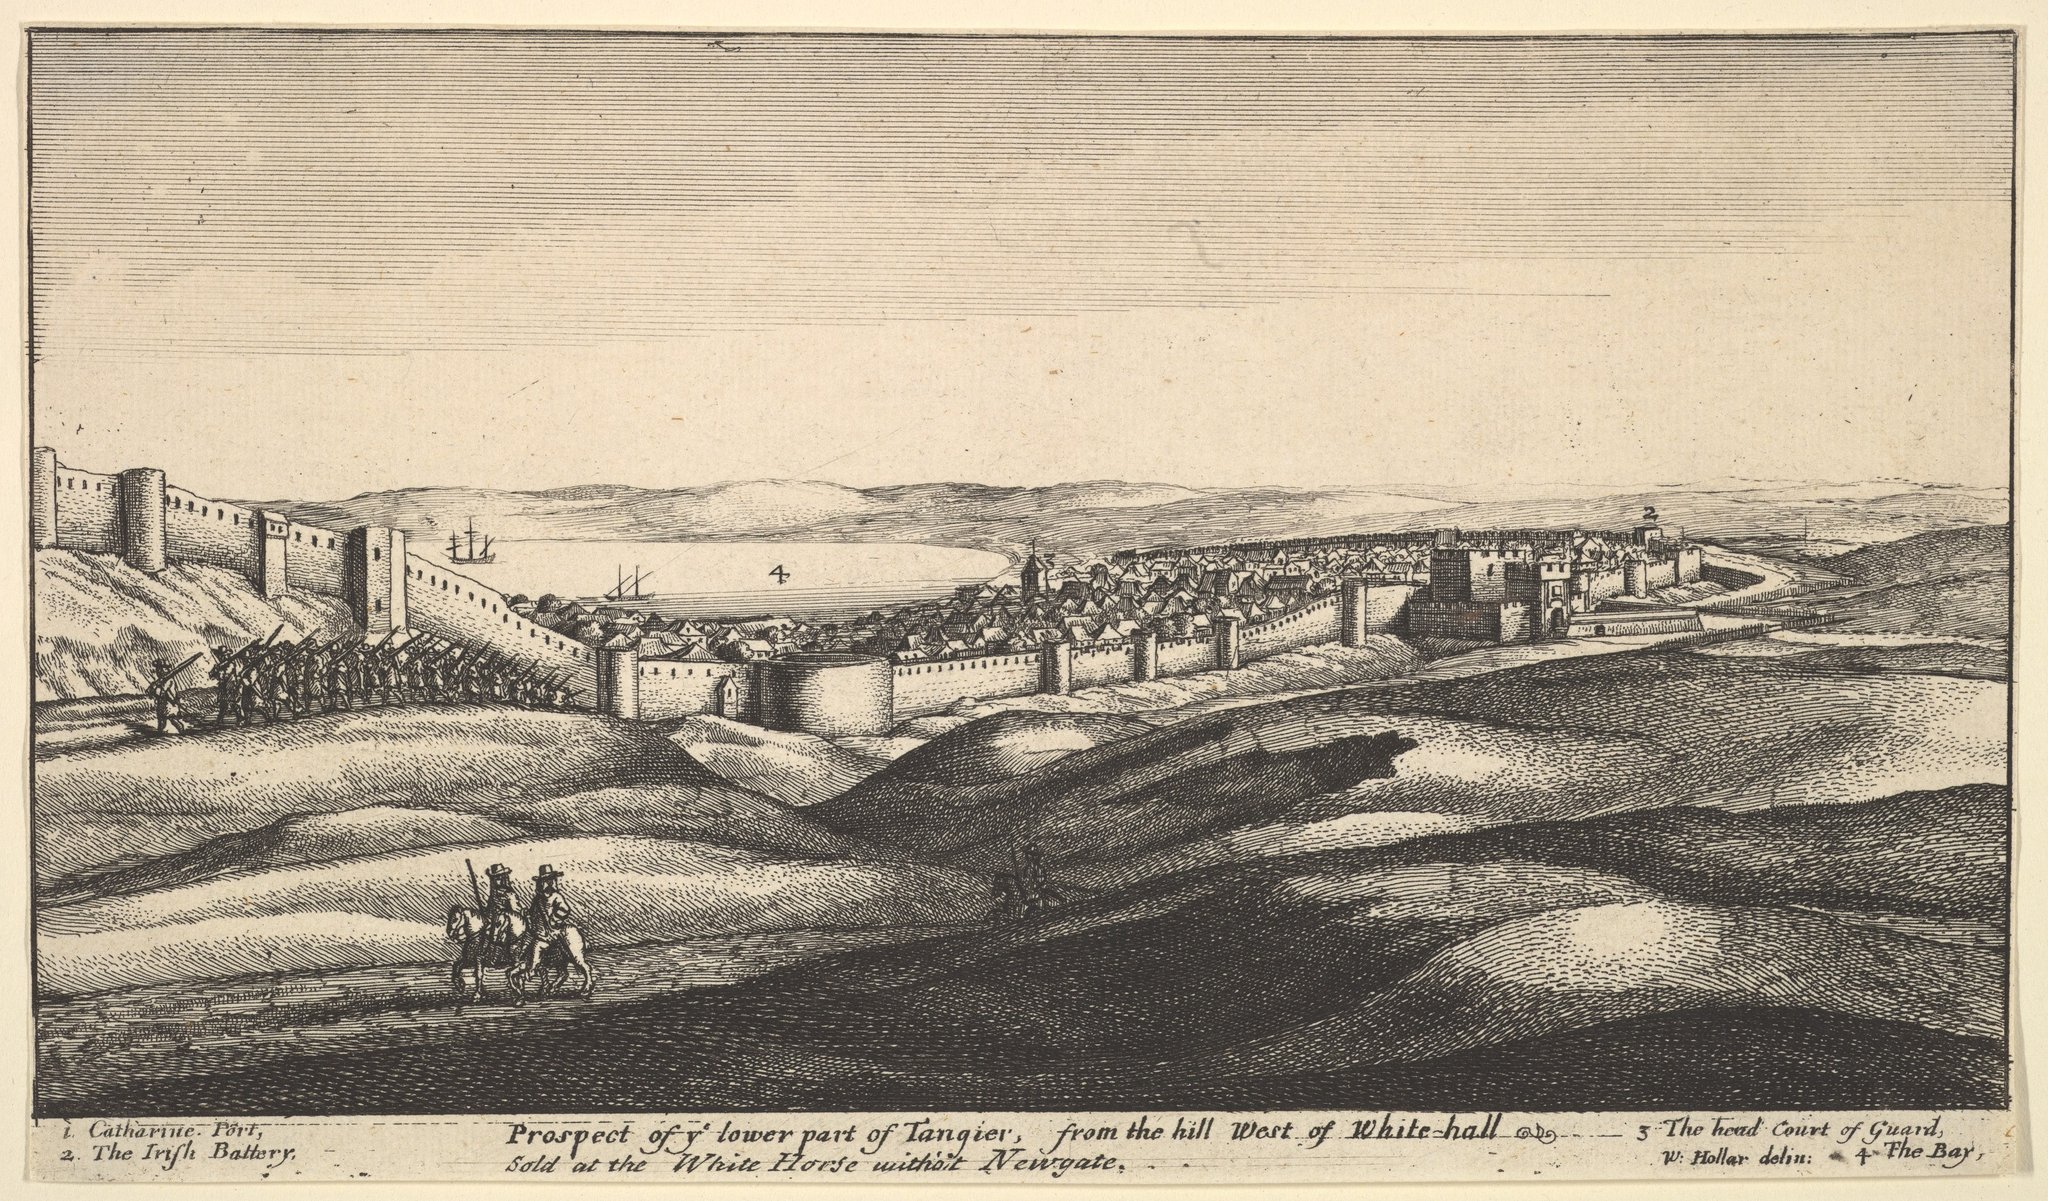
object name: print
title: Prospect of the Lower Part of Tangier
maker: wenceslaus hollar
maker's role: artist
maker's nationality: bohemian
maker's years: 1607-1677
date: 1670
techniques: etching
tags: fortification,cities,horses